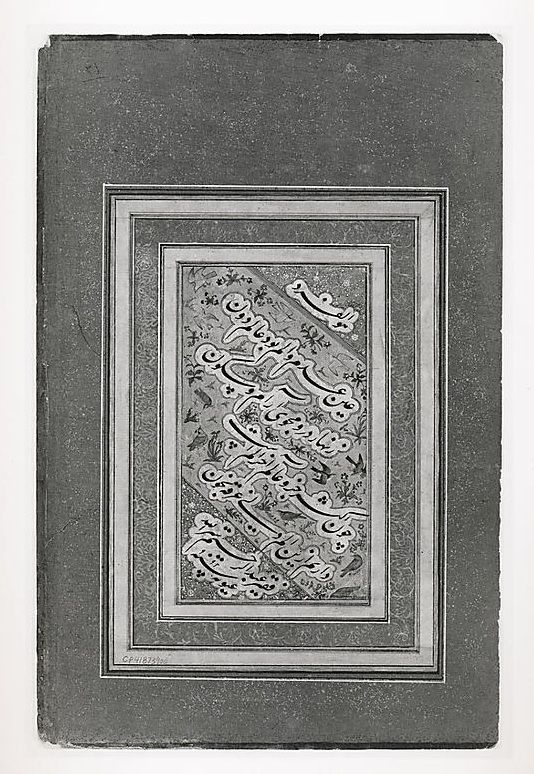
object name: non illustrated album leaf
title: Page of Calligraphy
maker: 'abd al-rahim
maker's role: calligrapher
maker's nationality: indian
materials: gold, ink, paper, watercolor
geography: india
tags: poetry,calligraphy